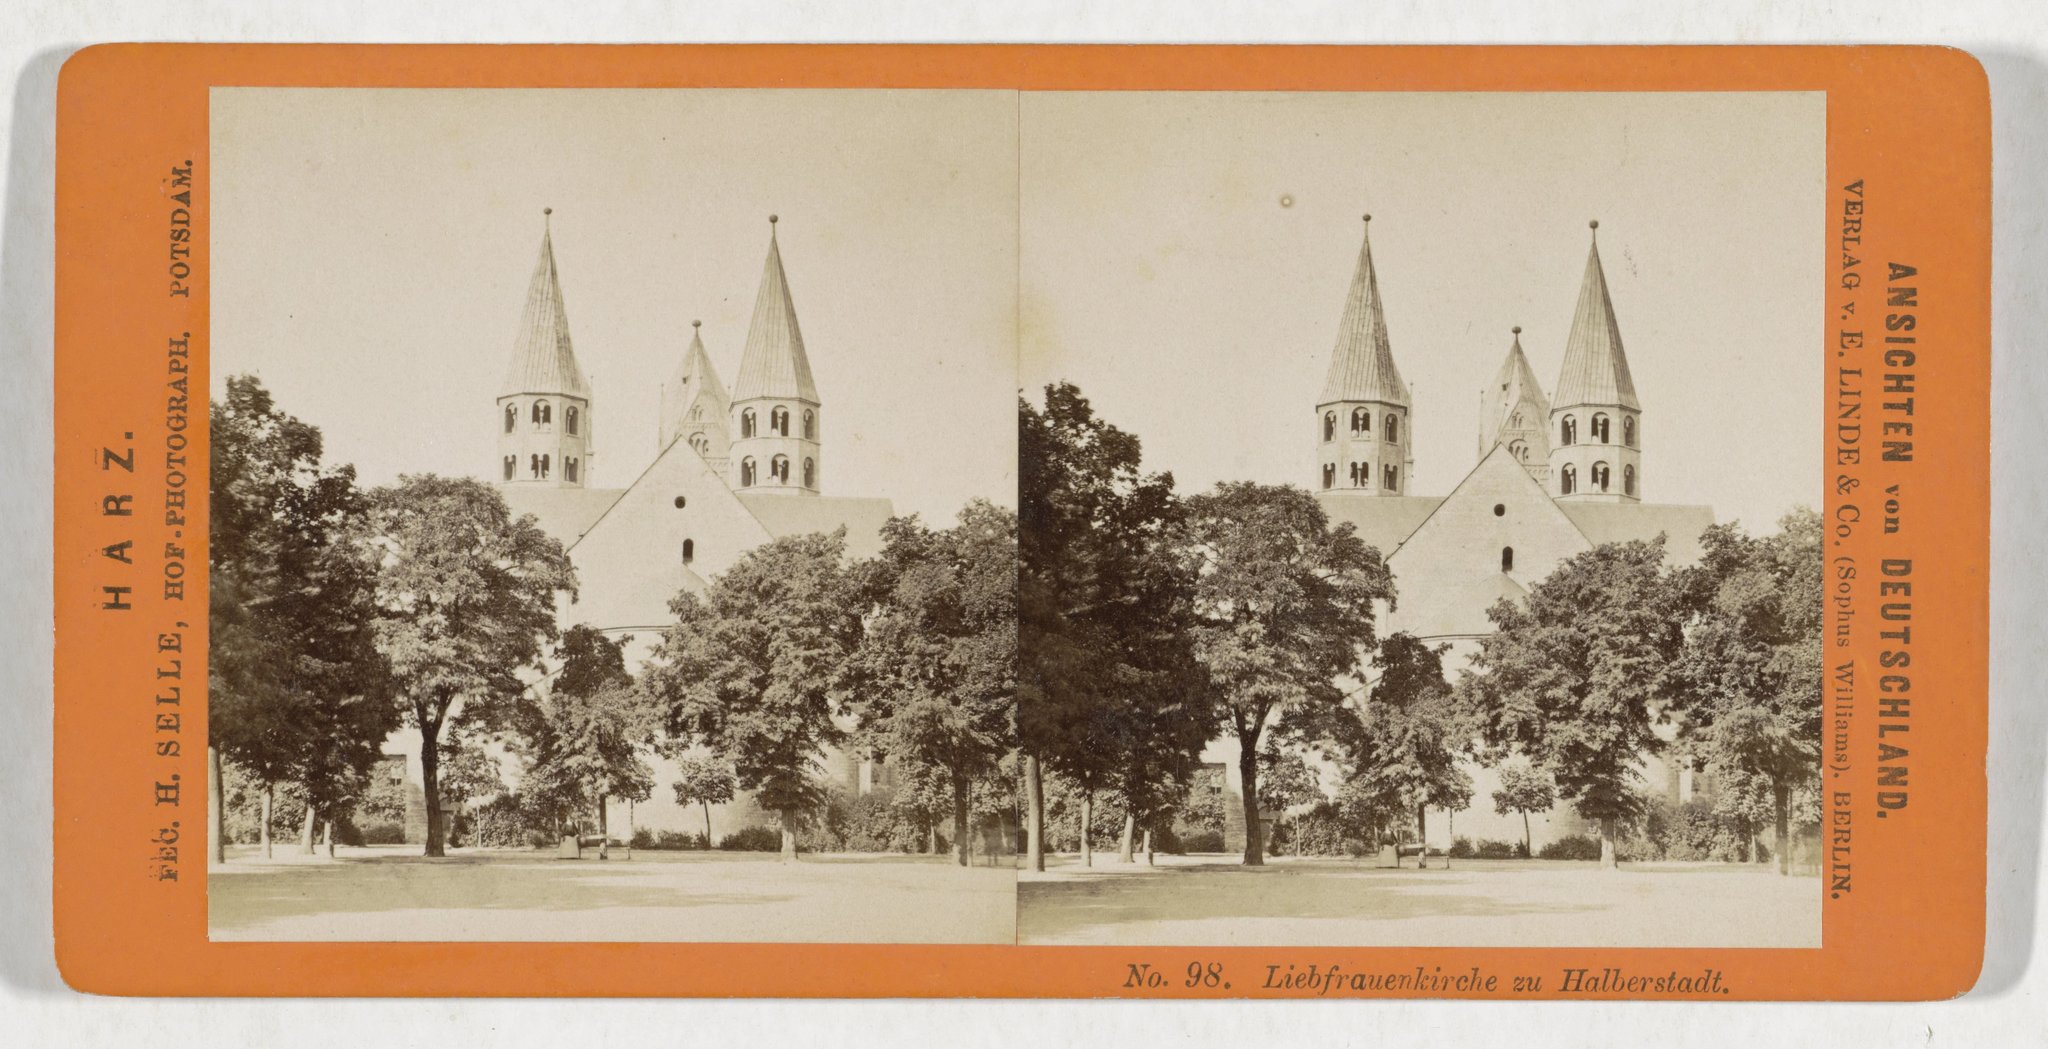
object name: stereograph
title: Liebfrauenkirche zu Halberstadt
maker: hermann selle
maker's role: fotograaf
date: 1868-1890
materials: cardboard, paper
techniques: albumen print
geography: halberstadt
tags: square, place, circus, etc., church (exterior)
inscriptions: inscription: ‘Hof-Photograph. Potsdam.’, number: ‘No. 98.’